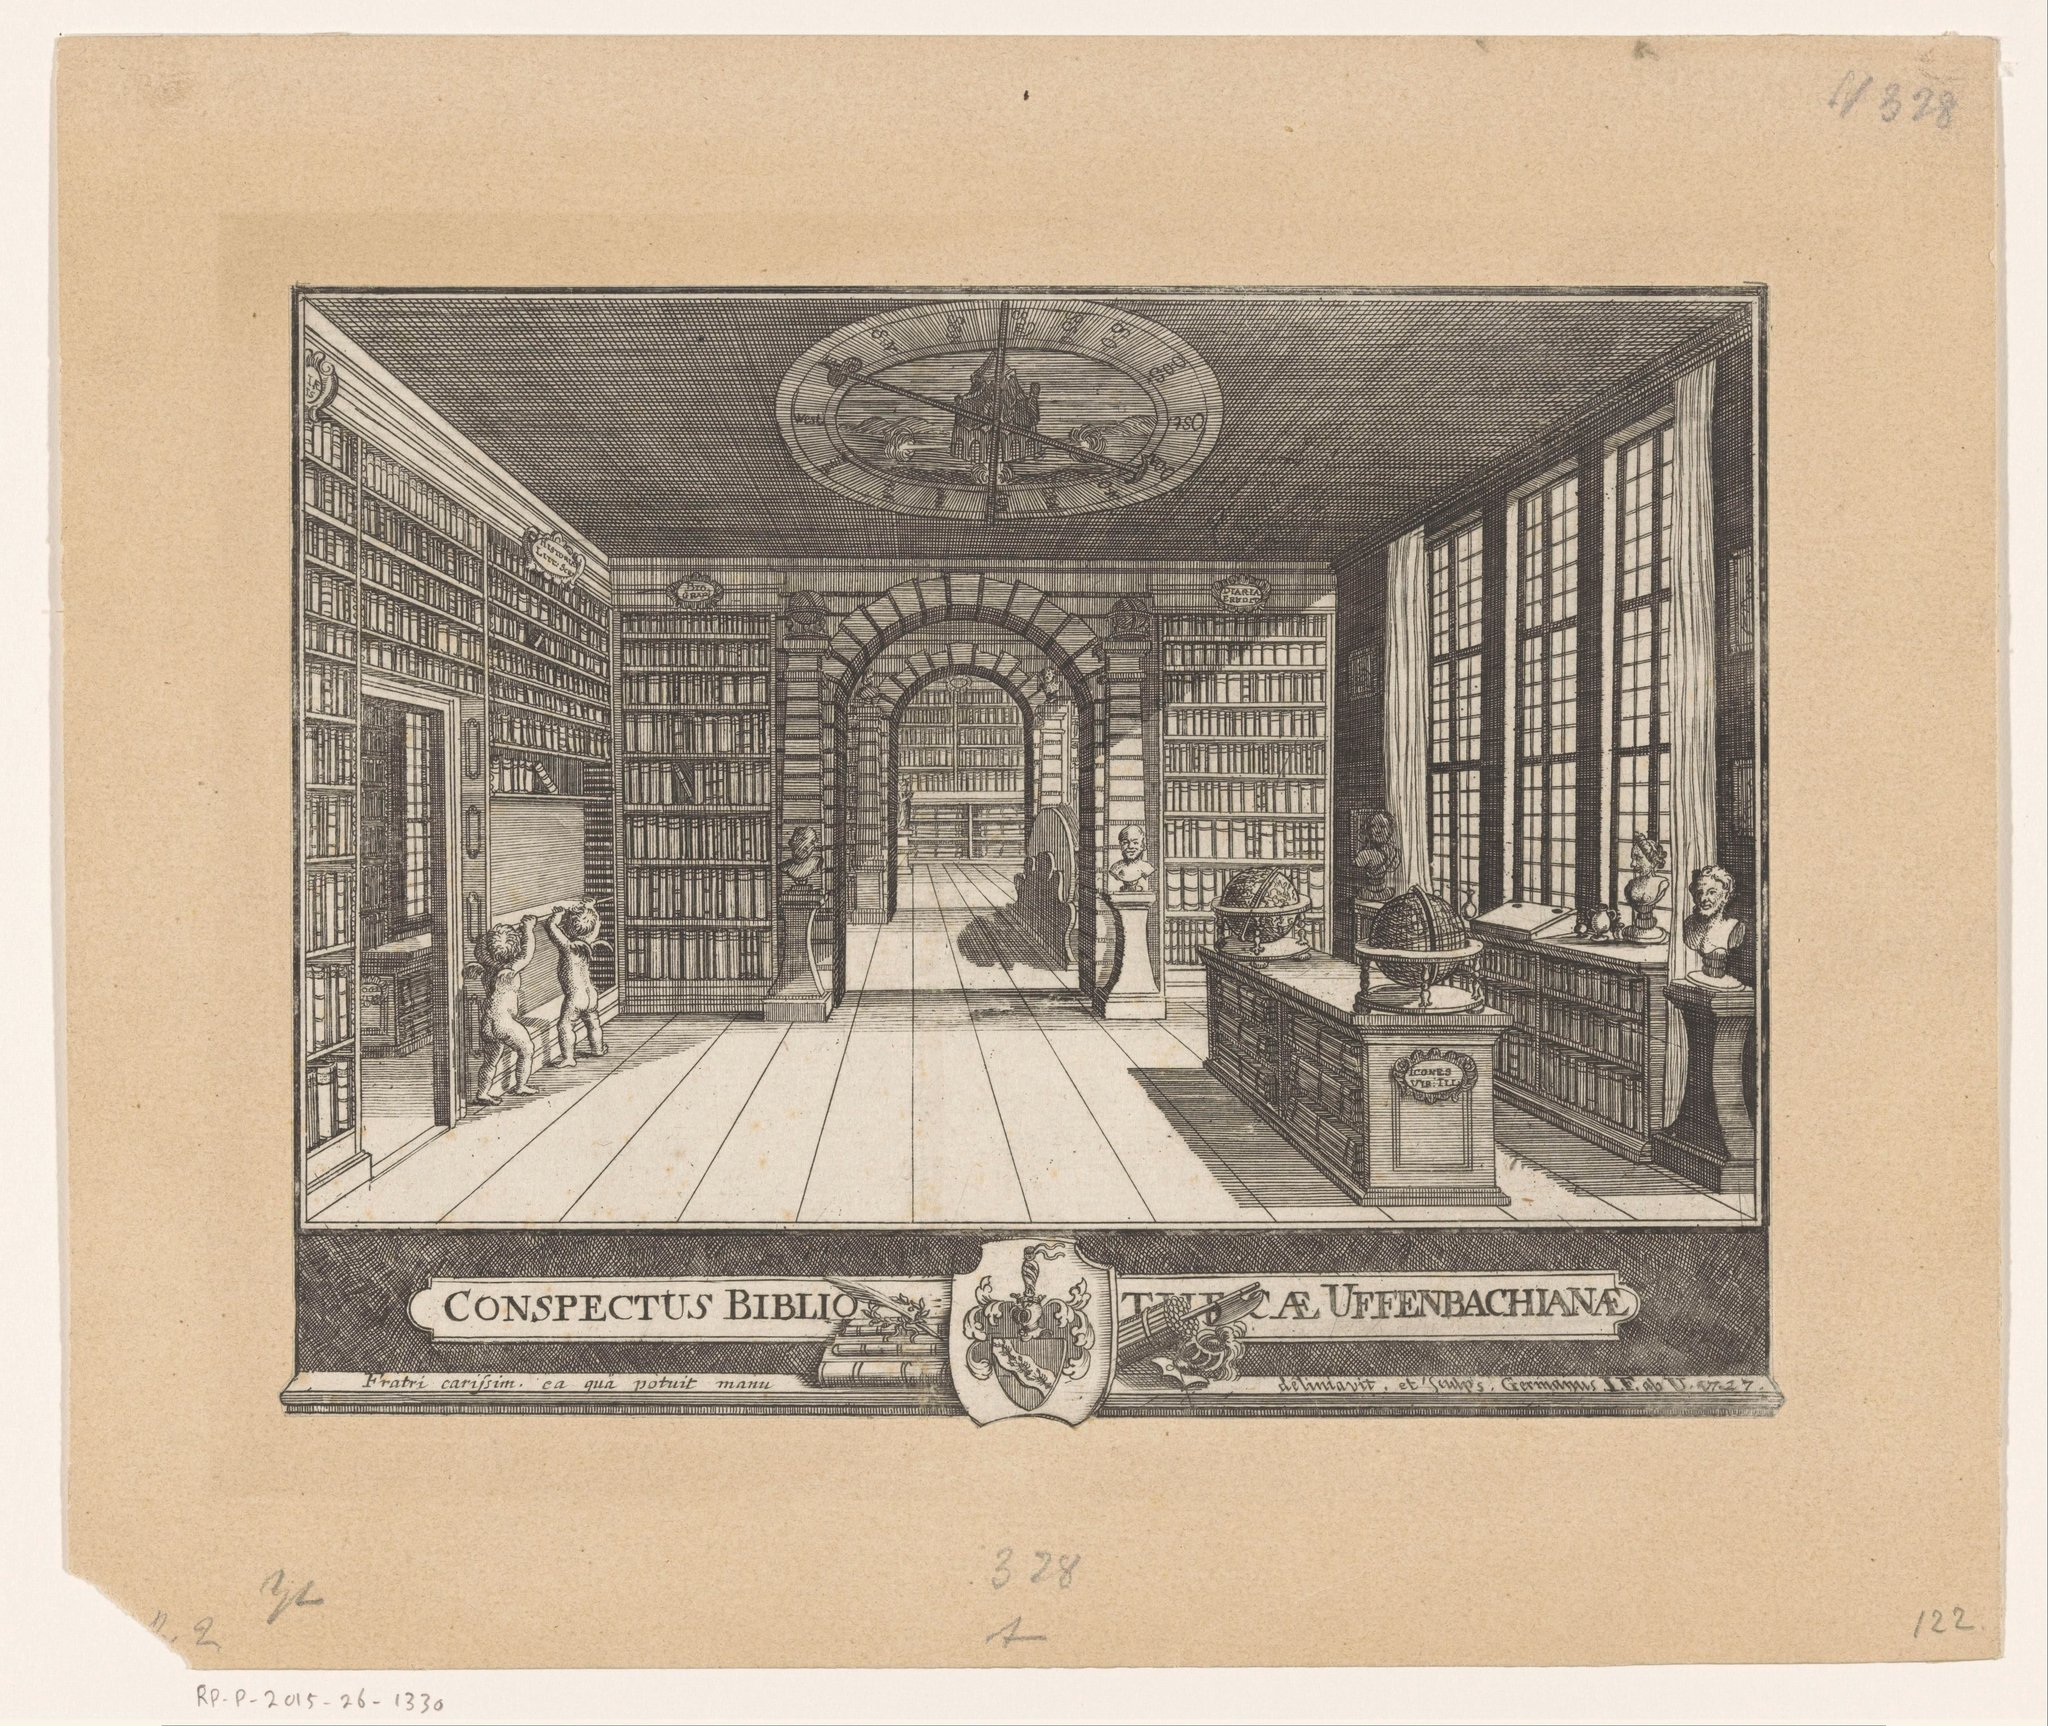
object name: print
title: Conspectus Bibliothecae Uffenbachianae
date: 1729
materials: paper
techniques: engraving, etching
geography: frankfurt am main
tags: study; 'studiolo'; library, globe, cupids: 'amores', 'amoretti', 'putti'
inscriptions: collector's mark: Lugt 2228, collector's mark: ‘His. Museum Frankfurt Dublette.’, collector's mark: Lugt 4779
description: Interieur van de bibliotheek van Zacharias Conrad von Uffenbach te Frankfurt am Main. De bibliotheek bestaat uit verschillende vertrekken. In het voorste vertrek staan twee globes op een kast met liggende folianten; aan het plafond hangt een windrichtingmeter. Links verstellen twee putti een boekenplank. In een naastgelegen vertrek is gedeelte van een leesrad te zien. Onder het wapen van Von Uffenbach met een stapel boeken en een roedenbundel.